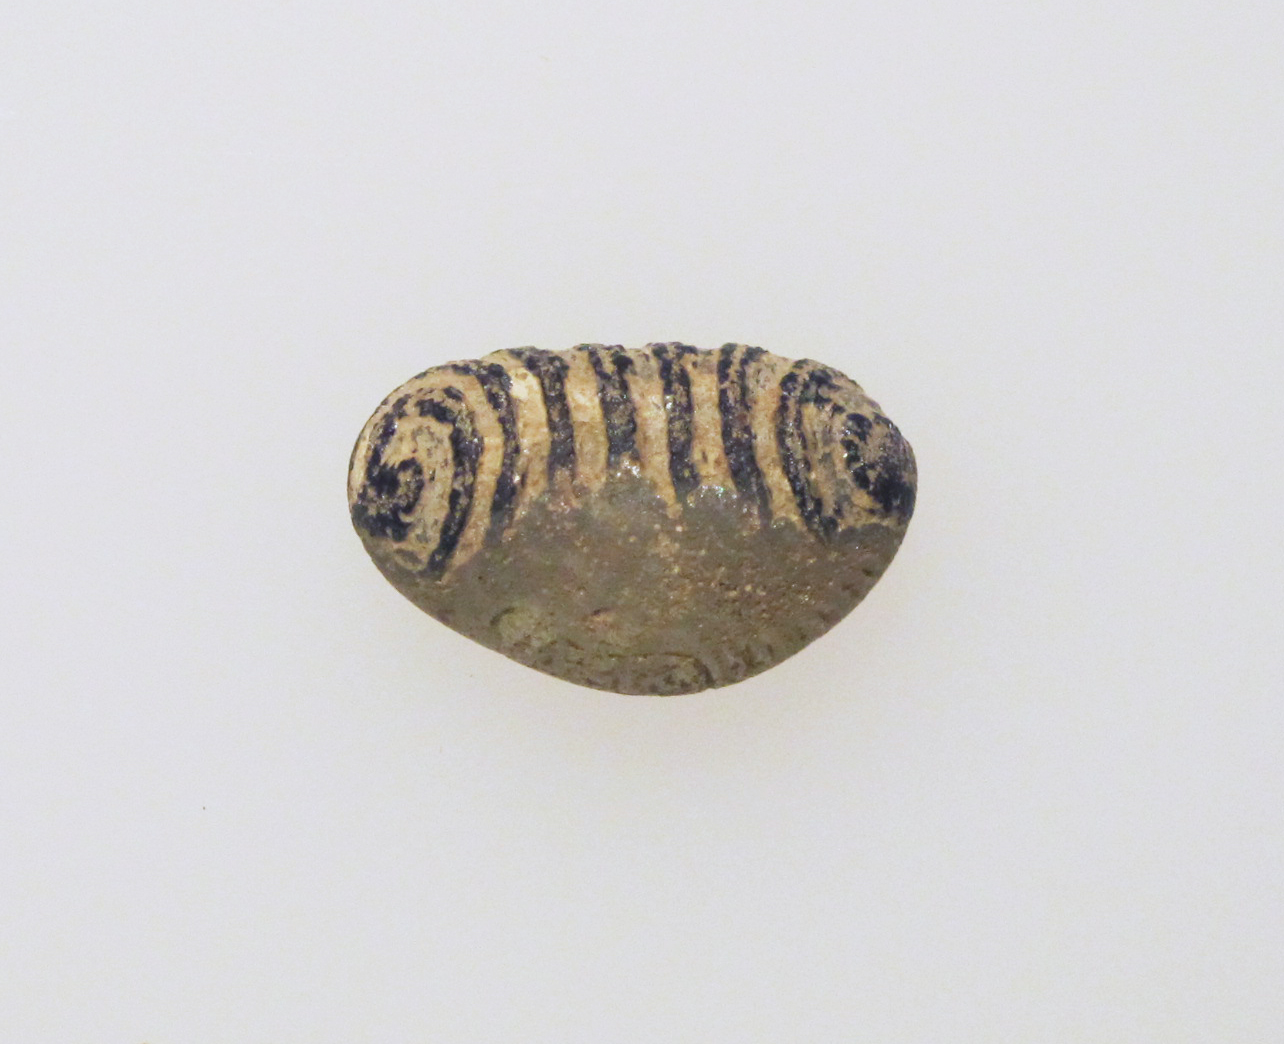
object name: pinhead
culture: roman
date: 670 BCE-330 CE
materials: glass